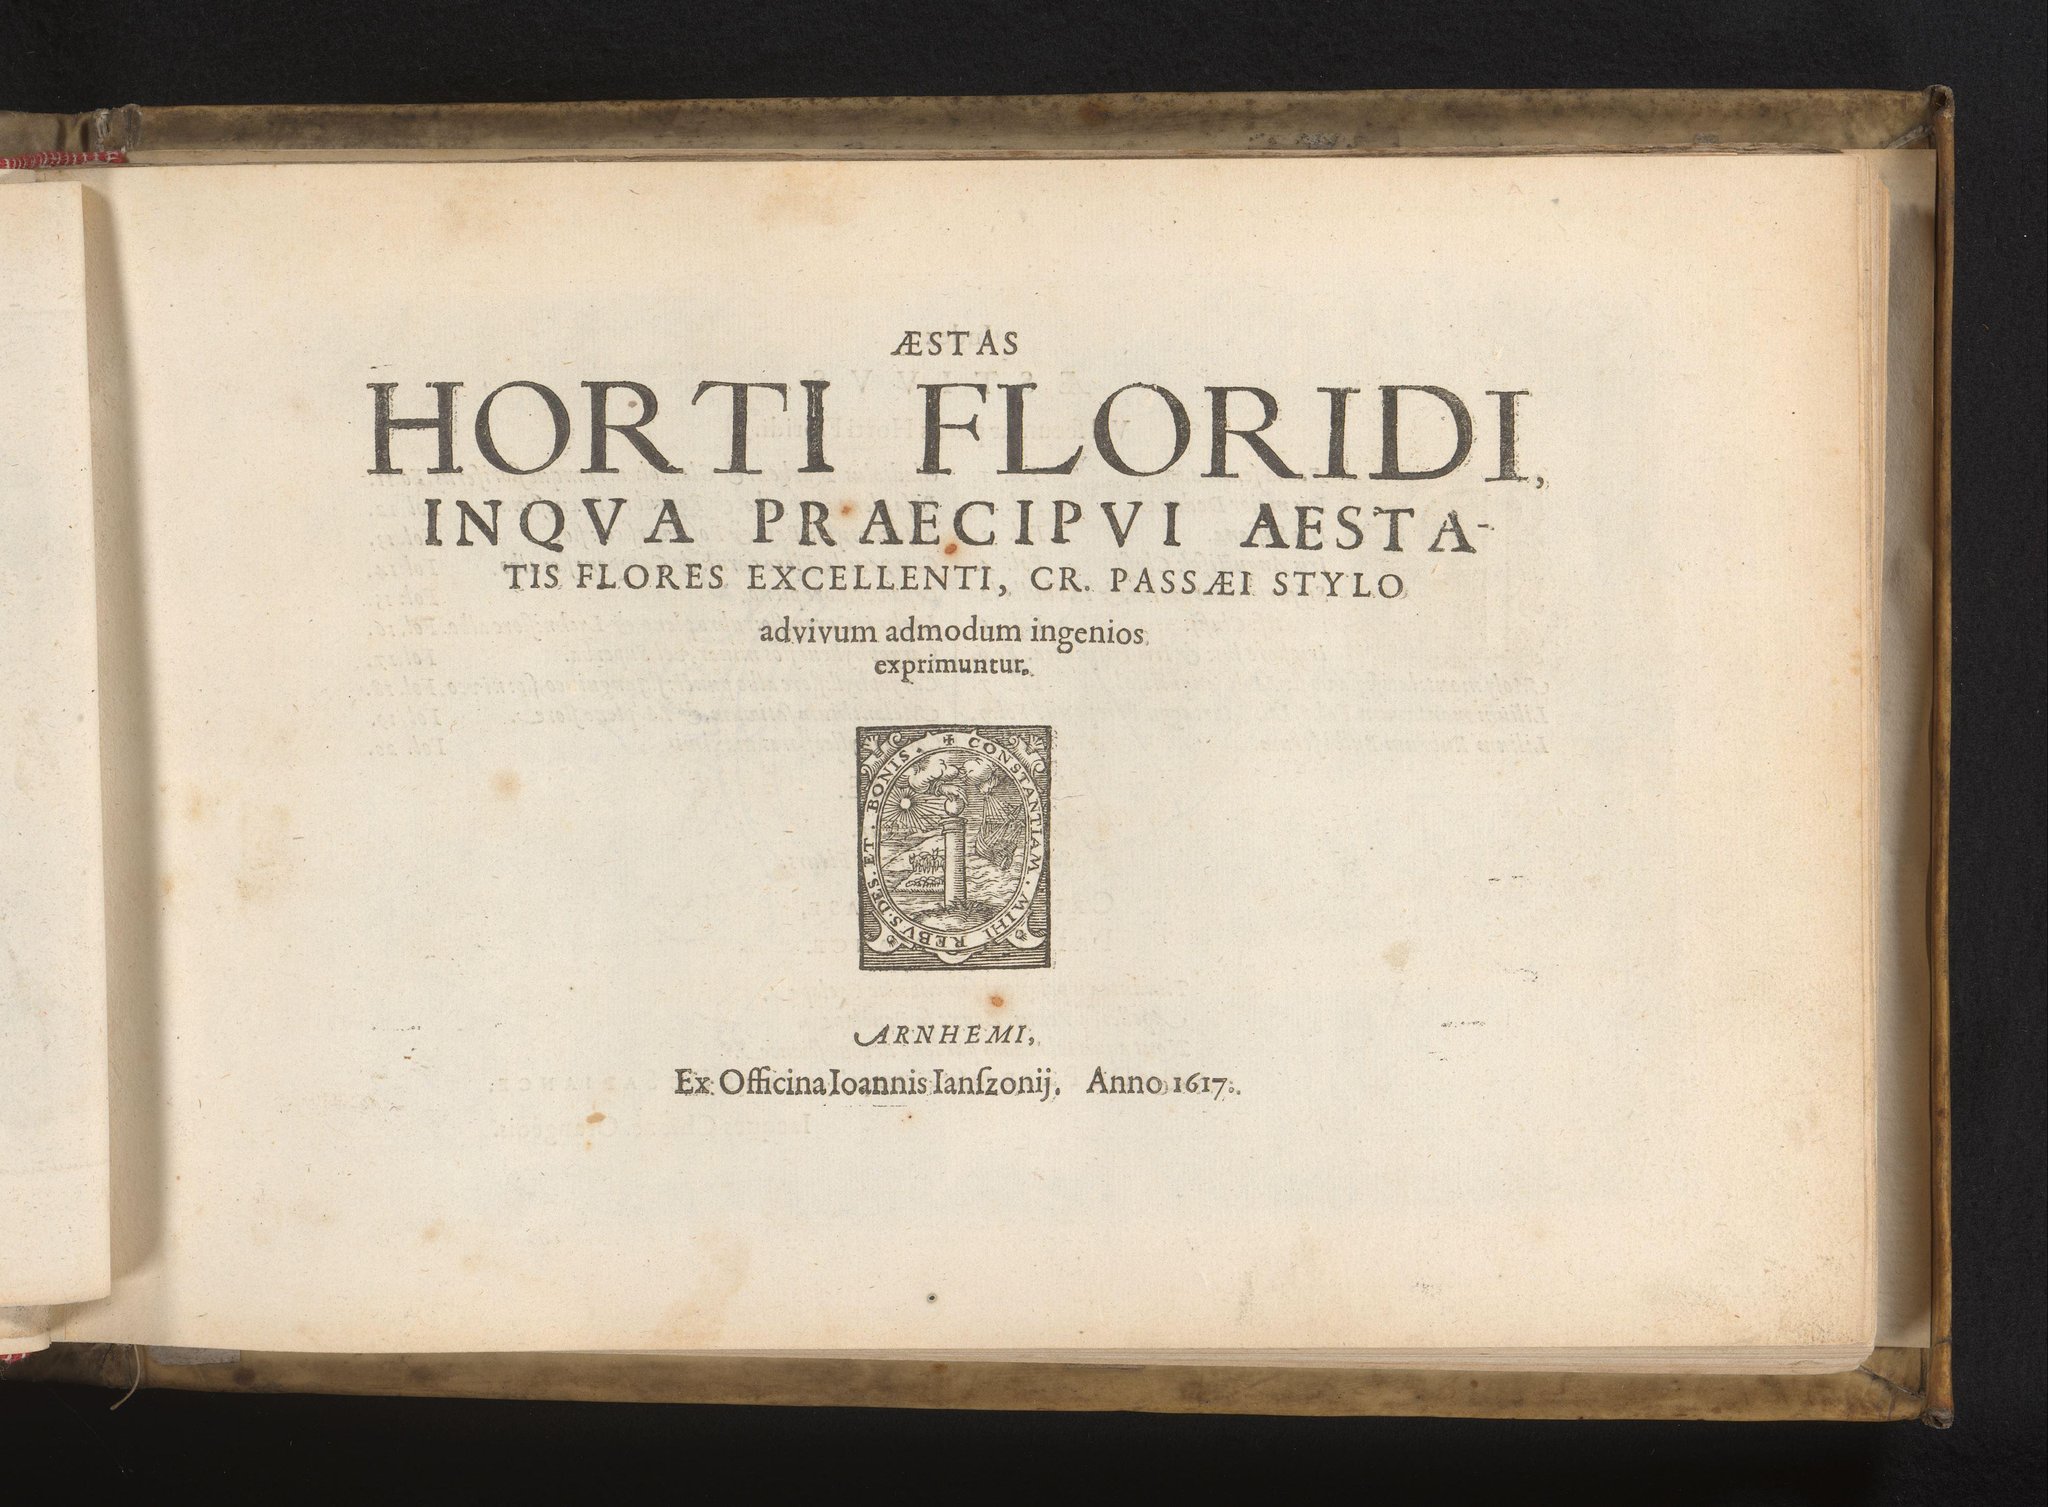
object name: print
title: Bloementuin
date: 1617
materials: paper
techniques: woodcut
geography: utrecht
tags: device (trade-mark of printer or publisher)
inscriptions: collector's mark: ‘Koninklijk Oudheidkundig Genootschap - Bibliotheek’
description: Titelprent voor 'Aestas horti floridi', het tweede deel van: Passe, Crispijn van de (II). Hortus floridus in quo rariorum & minus vulgarium florum icones ad vivam veramque formam. Arnhem: Johannes Janssonius, 1617.